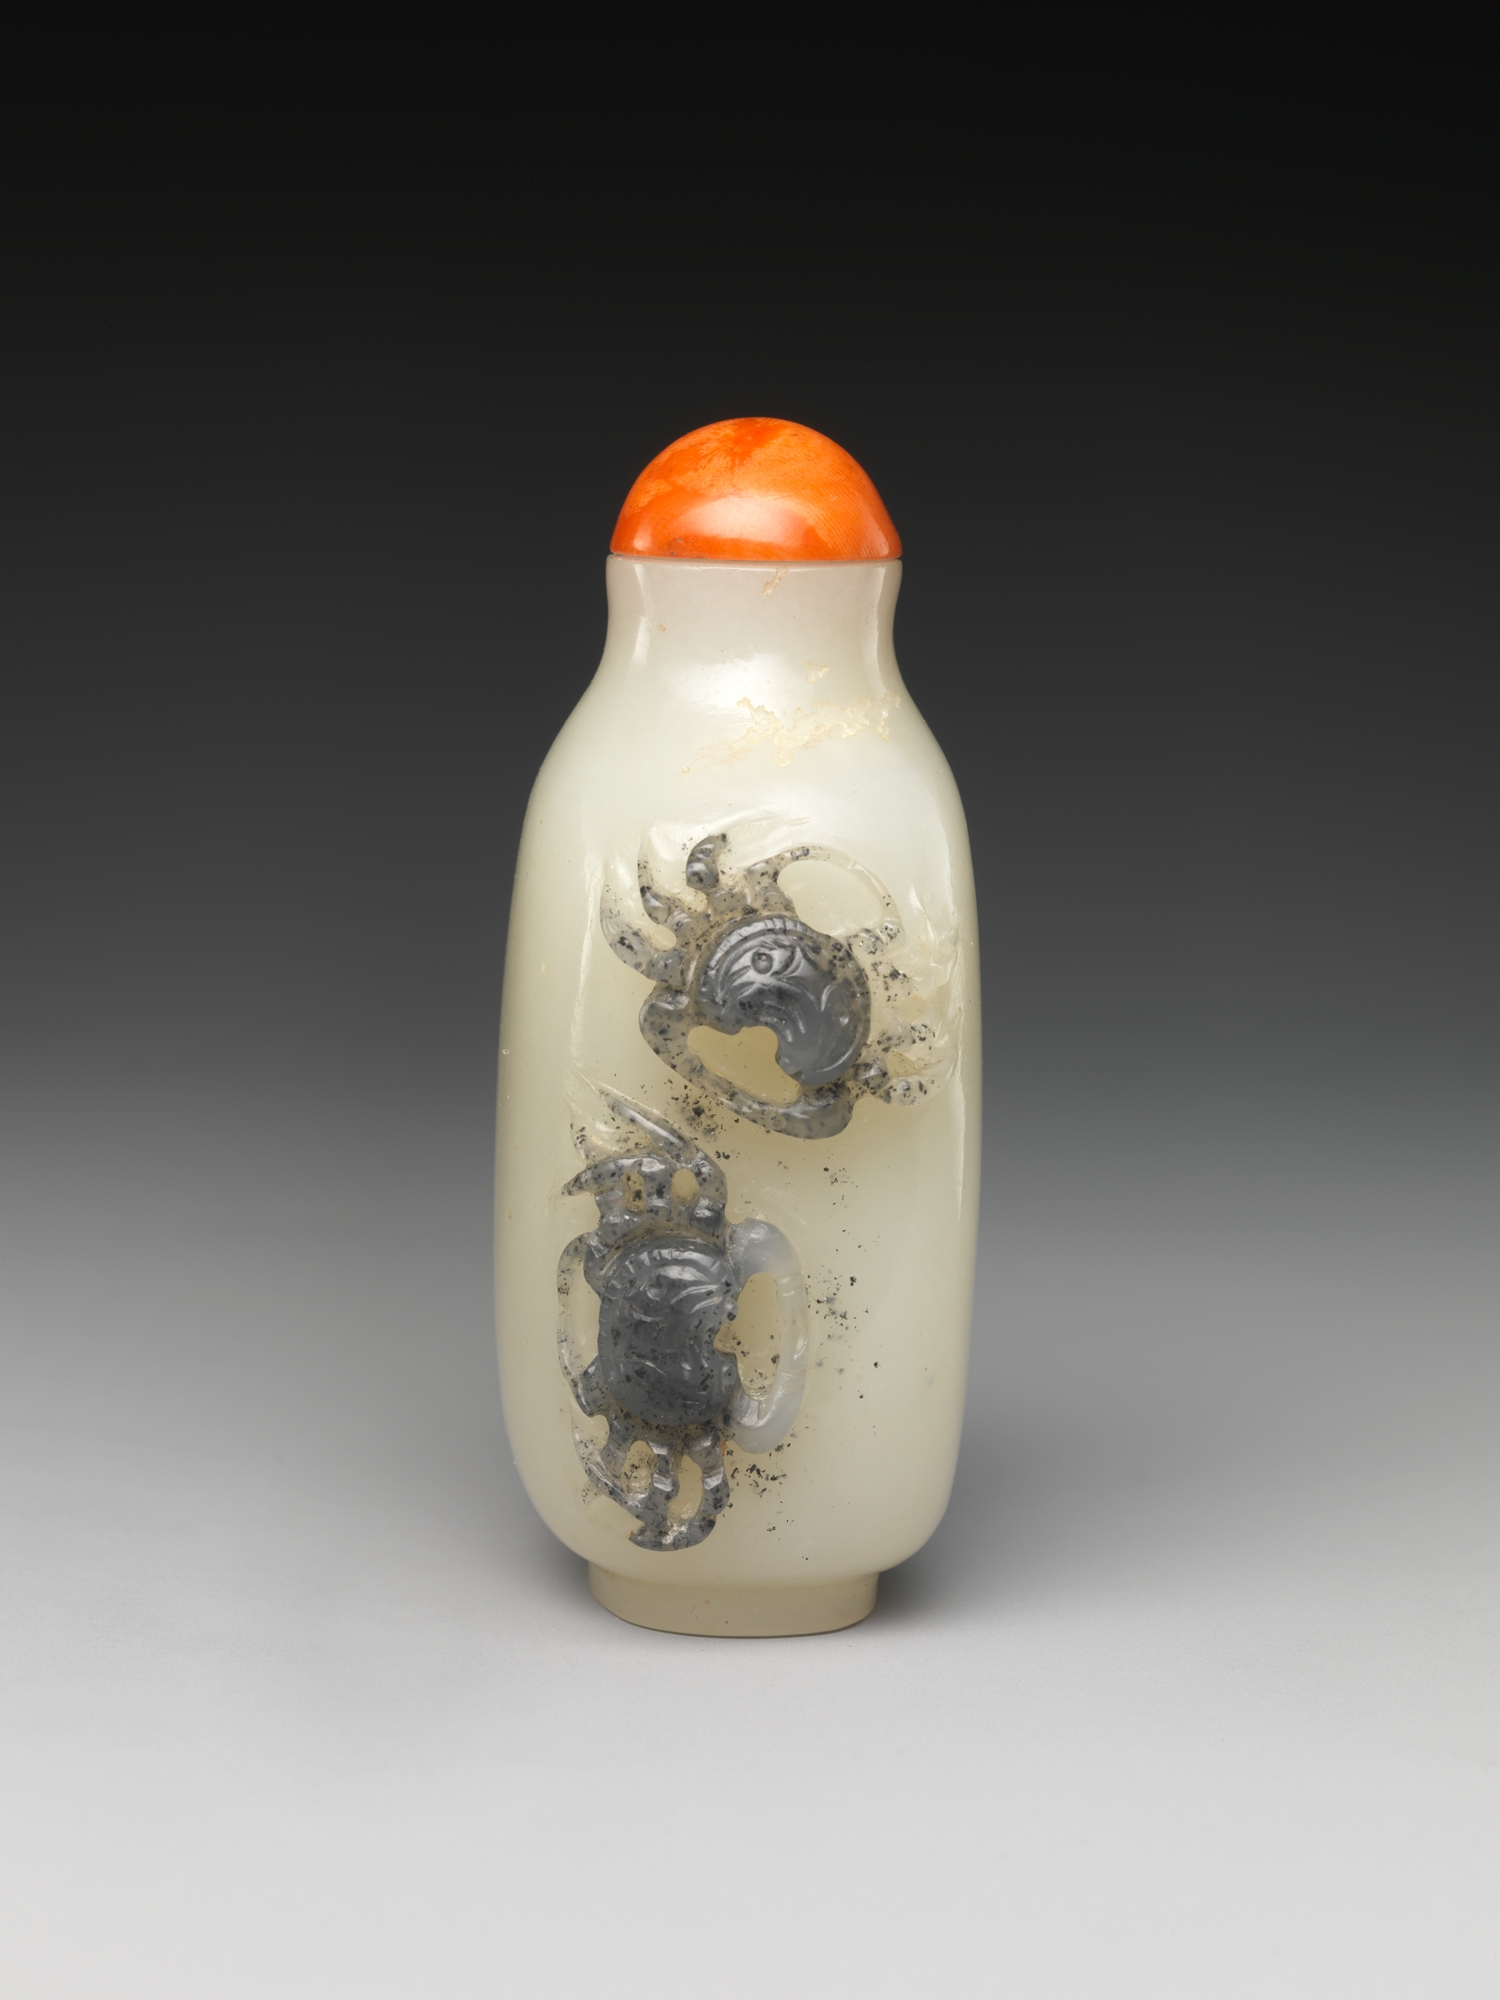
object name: snuff bottle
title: Snuff Bottle with Three Crabs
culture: chinese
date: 1767-1800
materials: coral, jade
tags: crabs